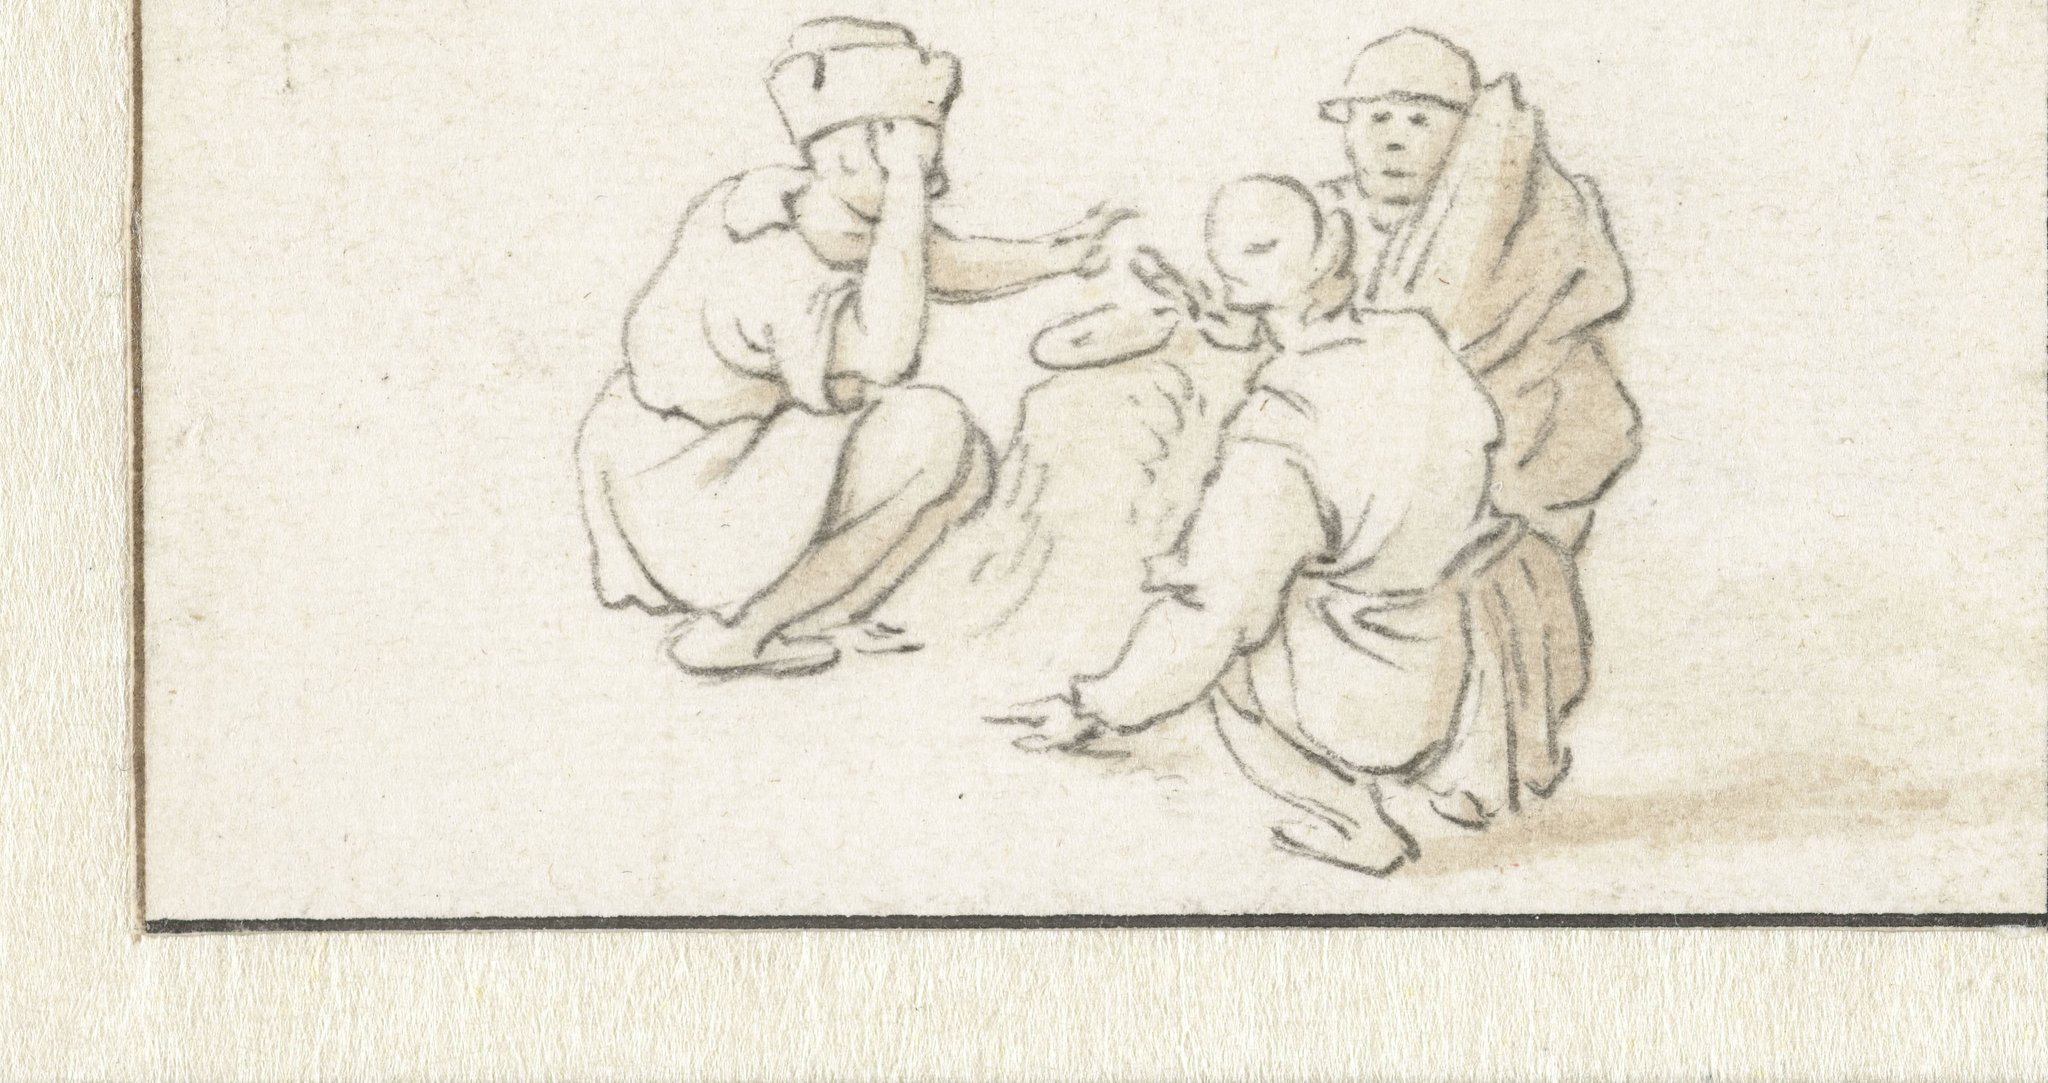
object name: drawing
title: Drie hurkende mannen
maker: herman saftleven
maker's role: draughtsman, painter, print maker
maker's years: 1609-1685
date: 1619-1685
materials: chalk, paper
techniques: brush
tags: squatting, crouching figure